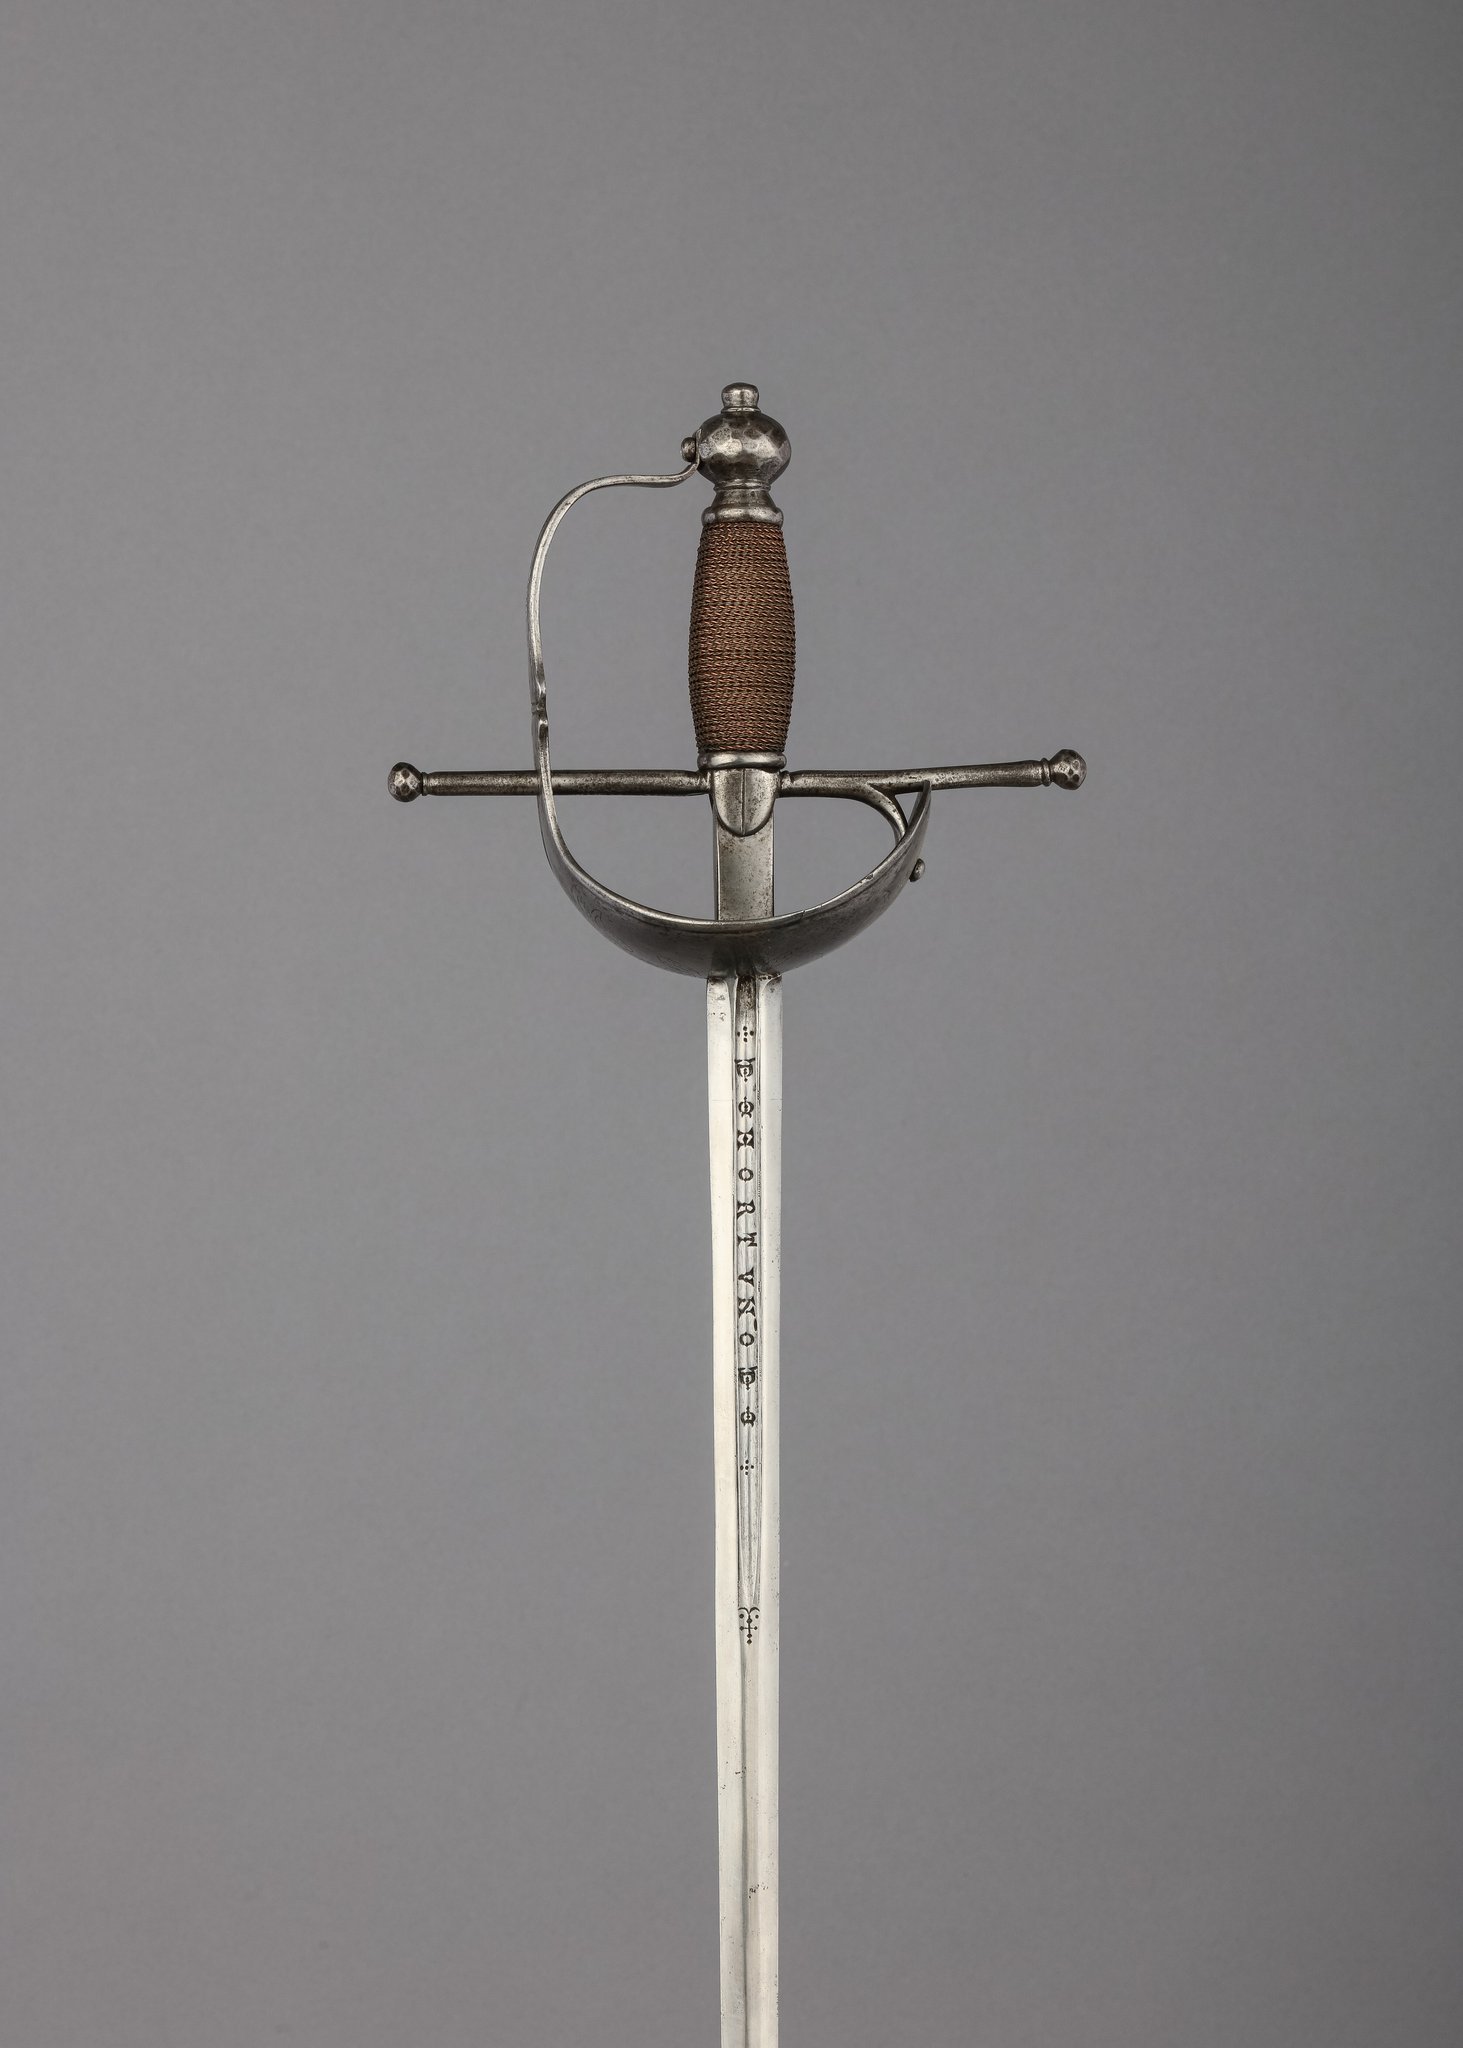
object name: rapier with scabbard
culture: spanish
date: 1701-1800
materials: copper, leather, steel, metal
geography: spain